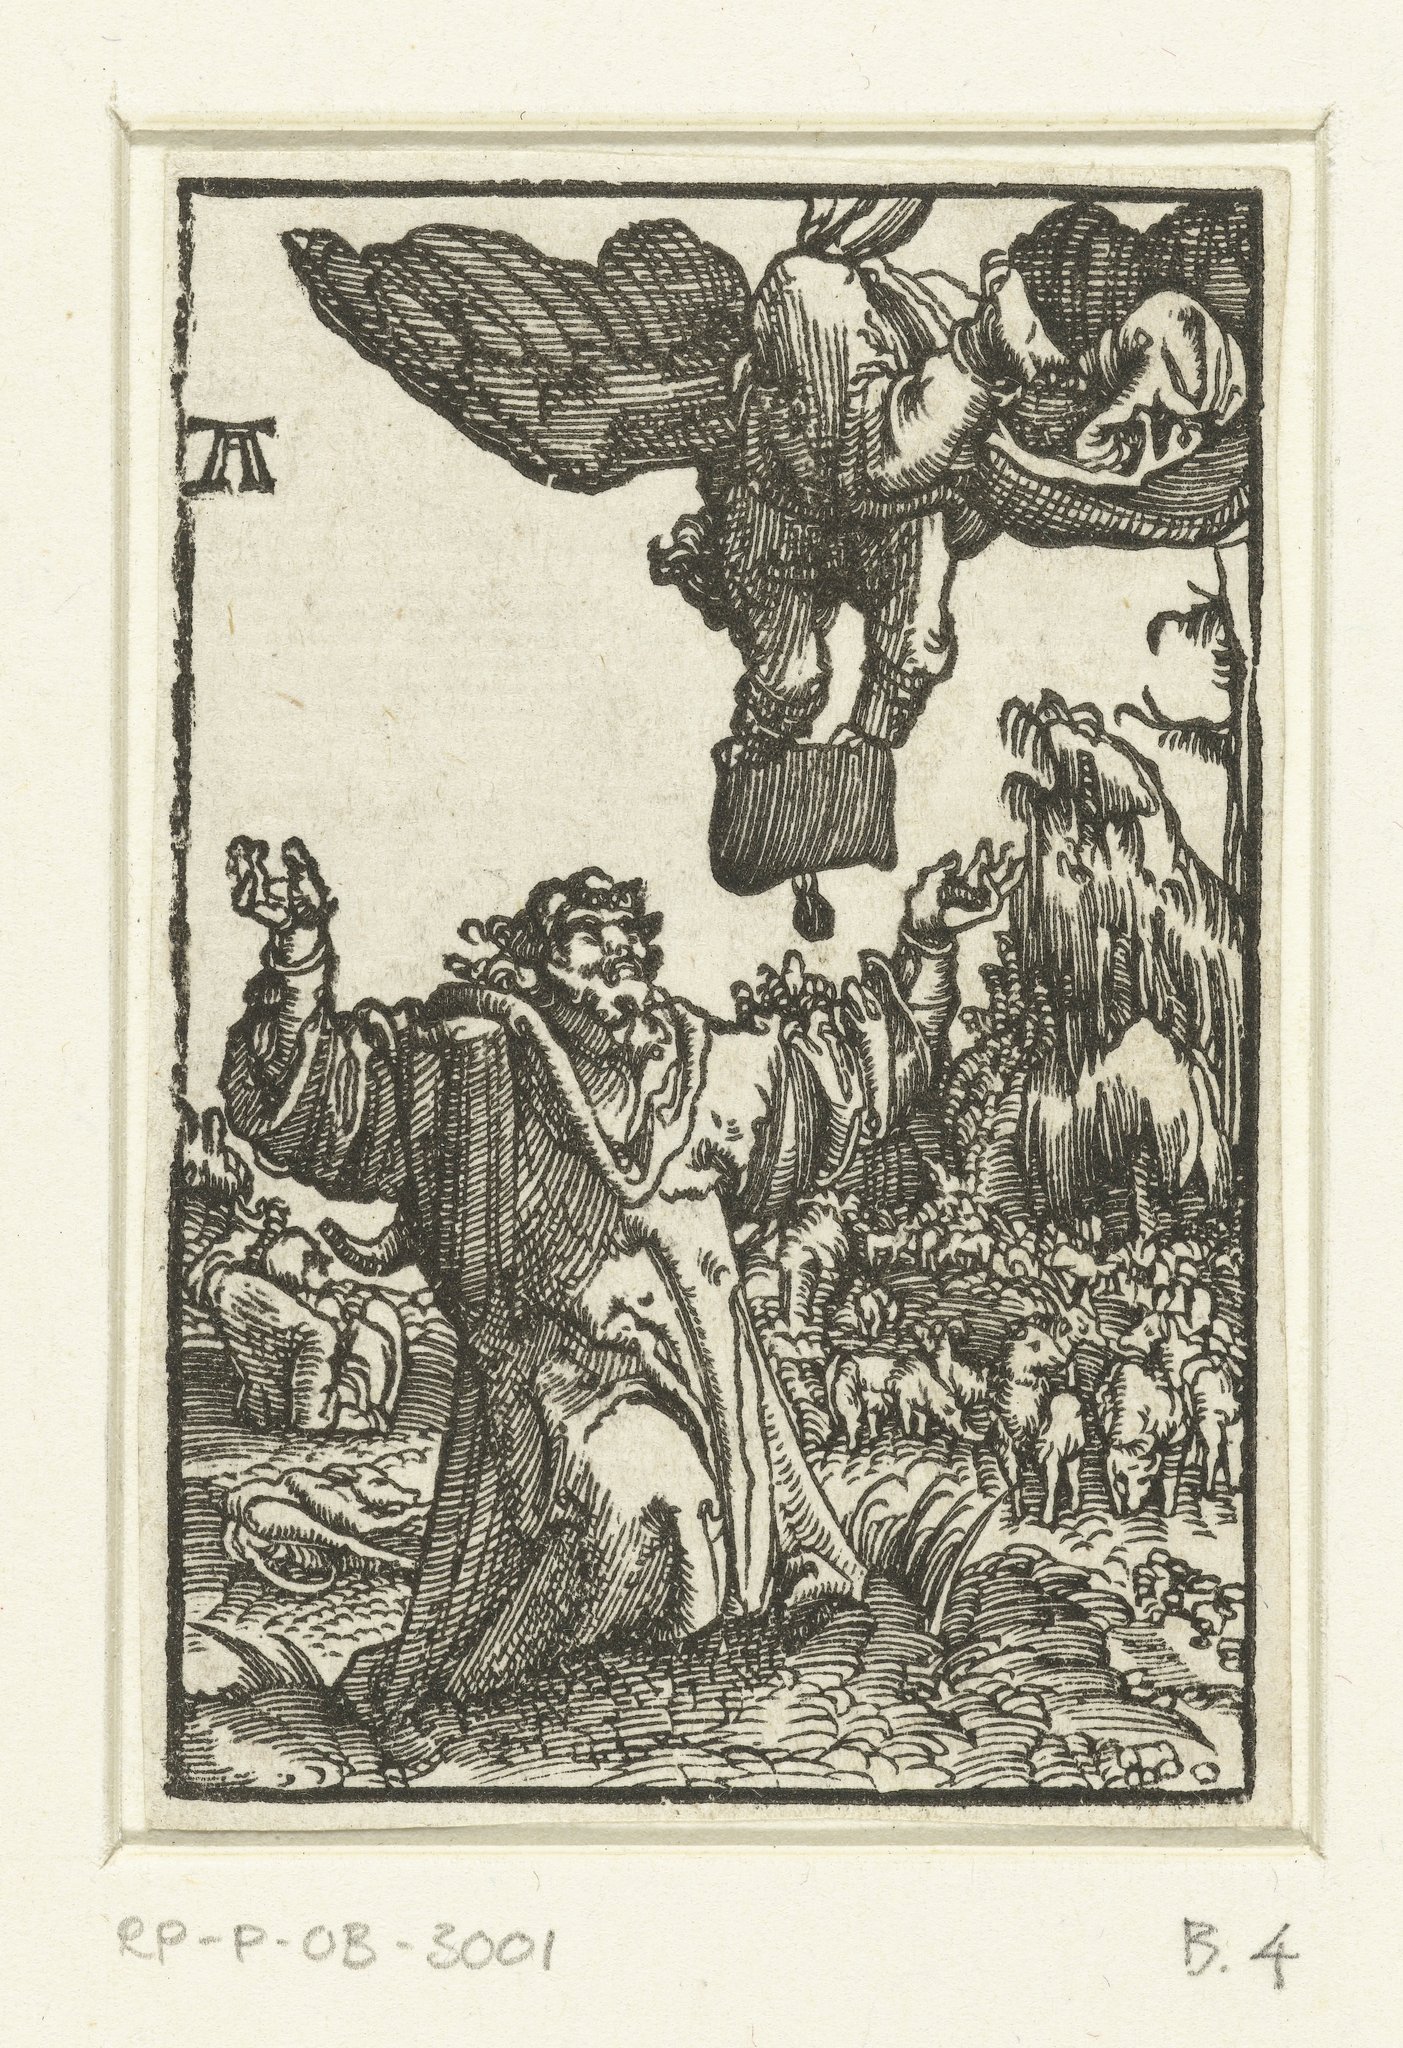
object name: print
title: De val en verlossing van de mensheid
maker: albrecht altdorfer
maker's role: draughtsman, print maker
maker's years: 1480-1538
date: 1506-1538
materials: paper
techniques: woodcut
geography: germany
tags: annunciation of the birth of mary to joachim by an angel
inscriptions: number: ‘58’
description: Joachim, geknield en met beide armen opgeheven. Boven hem zweeft een engel, op de rug gezien, met een object in zijn handen. Vierde prent uit een serie van veertig.